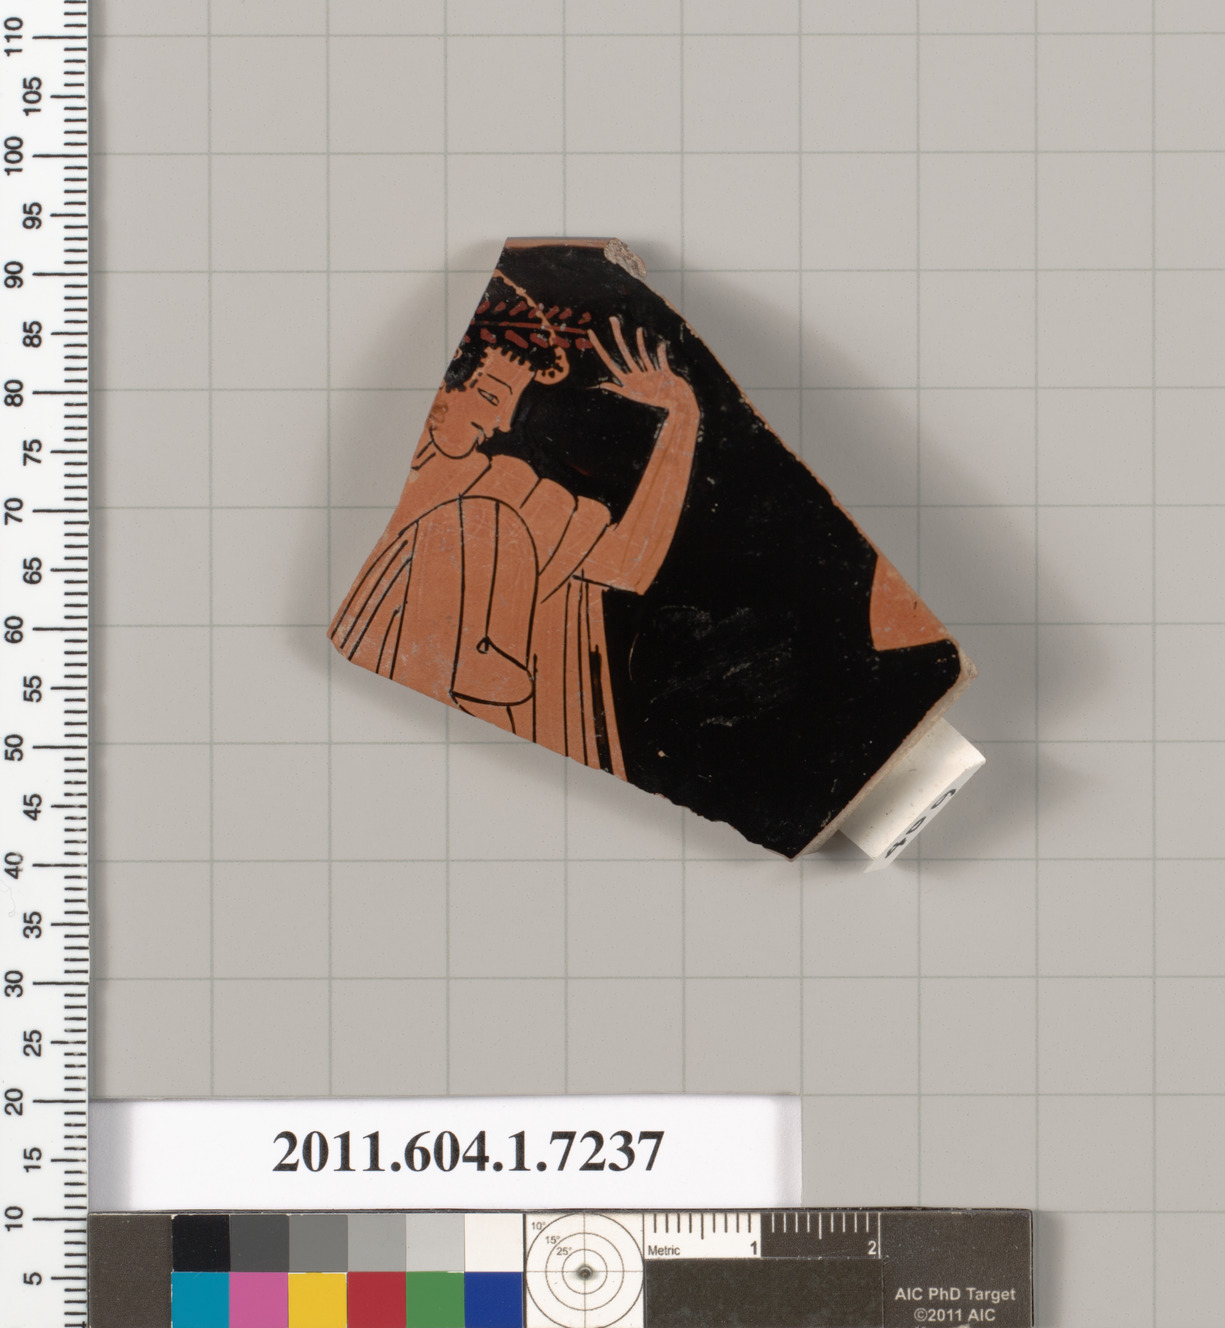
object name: kylix fragment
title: Terracotta rim fragment of a kylix (drinking cup)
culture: greek, attic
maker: makron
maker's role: artist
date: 500-480 BCE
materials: terracotta